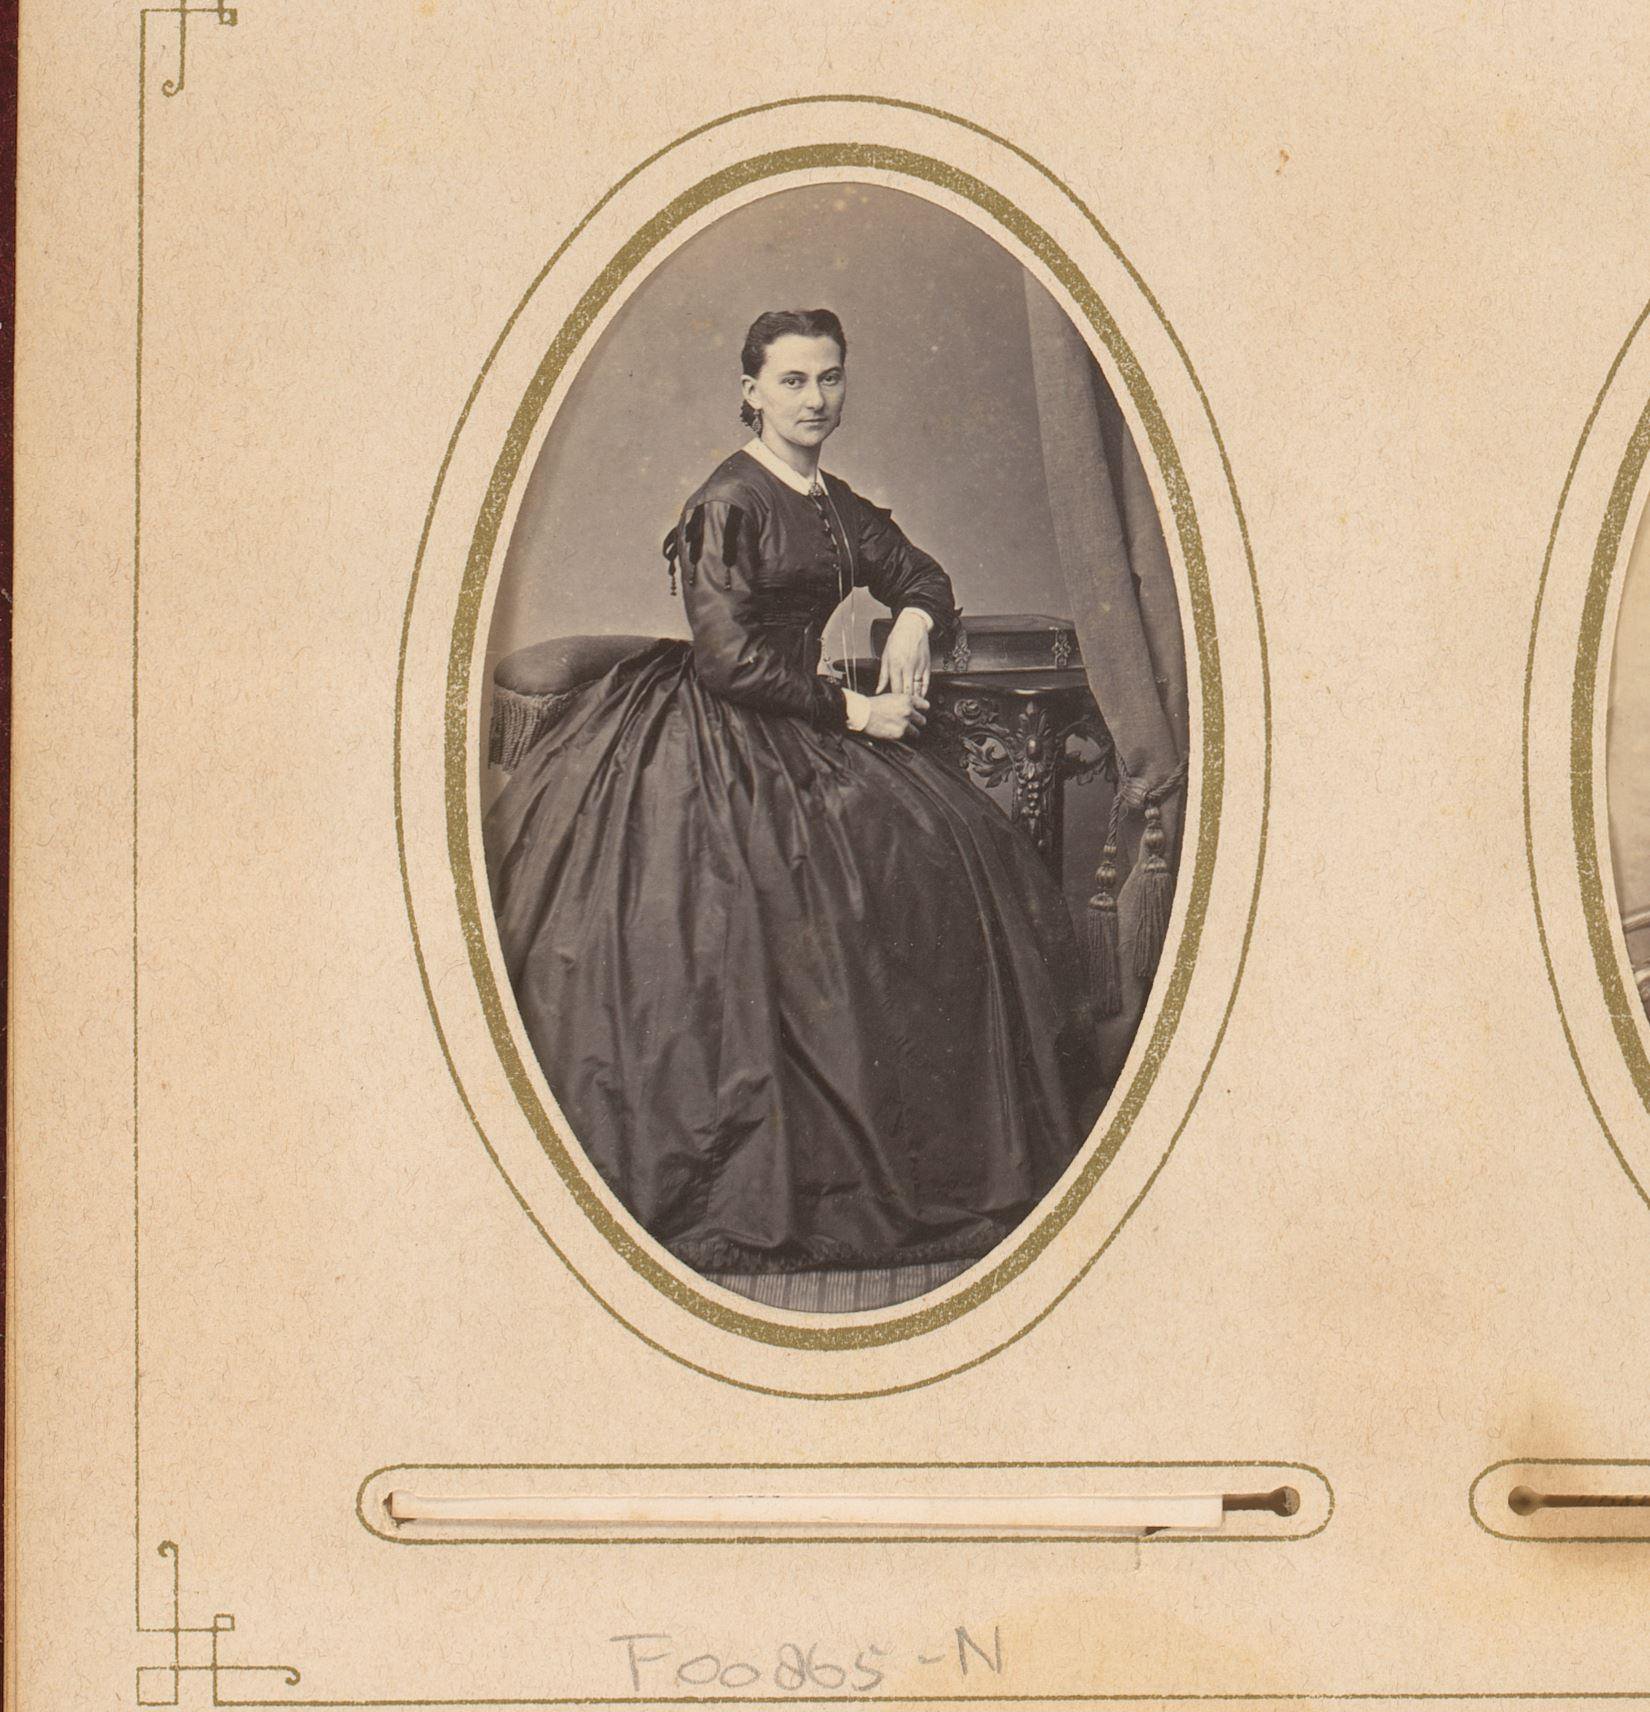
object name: album leaf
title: Portret van een vrouw, leunend op een boek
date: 1808-1865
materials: cardboard, photographic support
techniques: albumen print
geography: breda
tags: historical persons - bb - woman, book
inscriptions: date: ‘Augustus 1865’, inscription: ‘KANNEMANS & ZOON/ Artiste Photograph/ BREDA/ Groote Markt D. 15/ tegenover het Stadhuis’